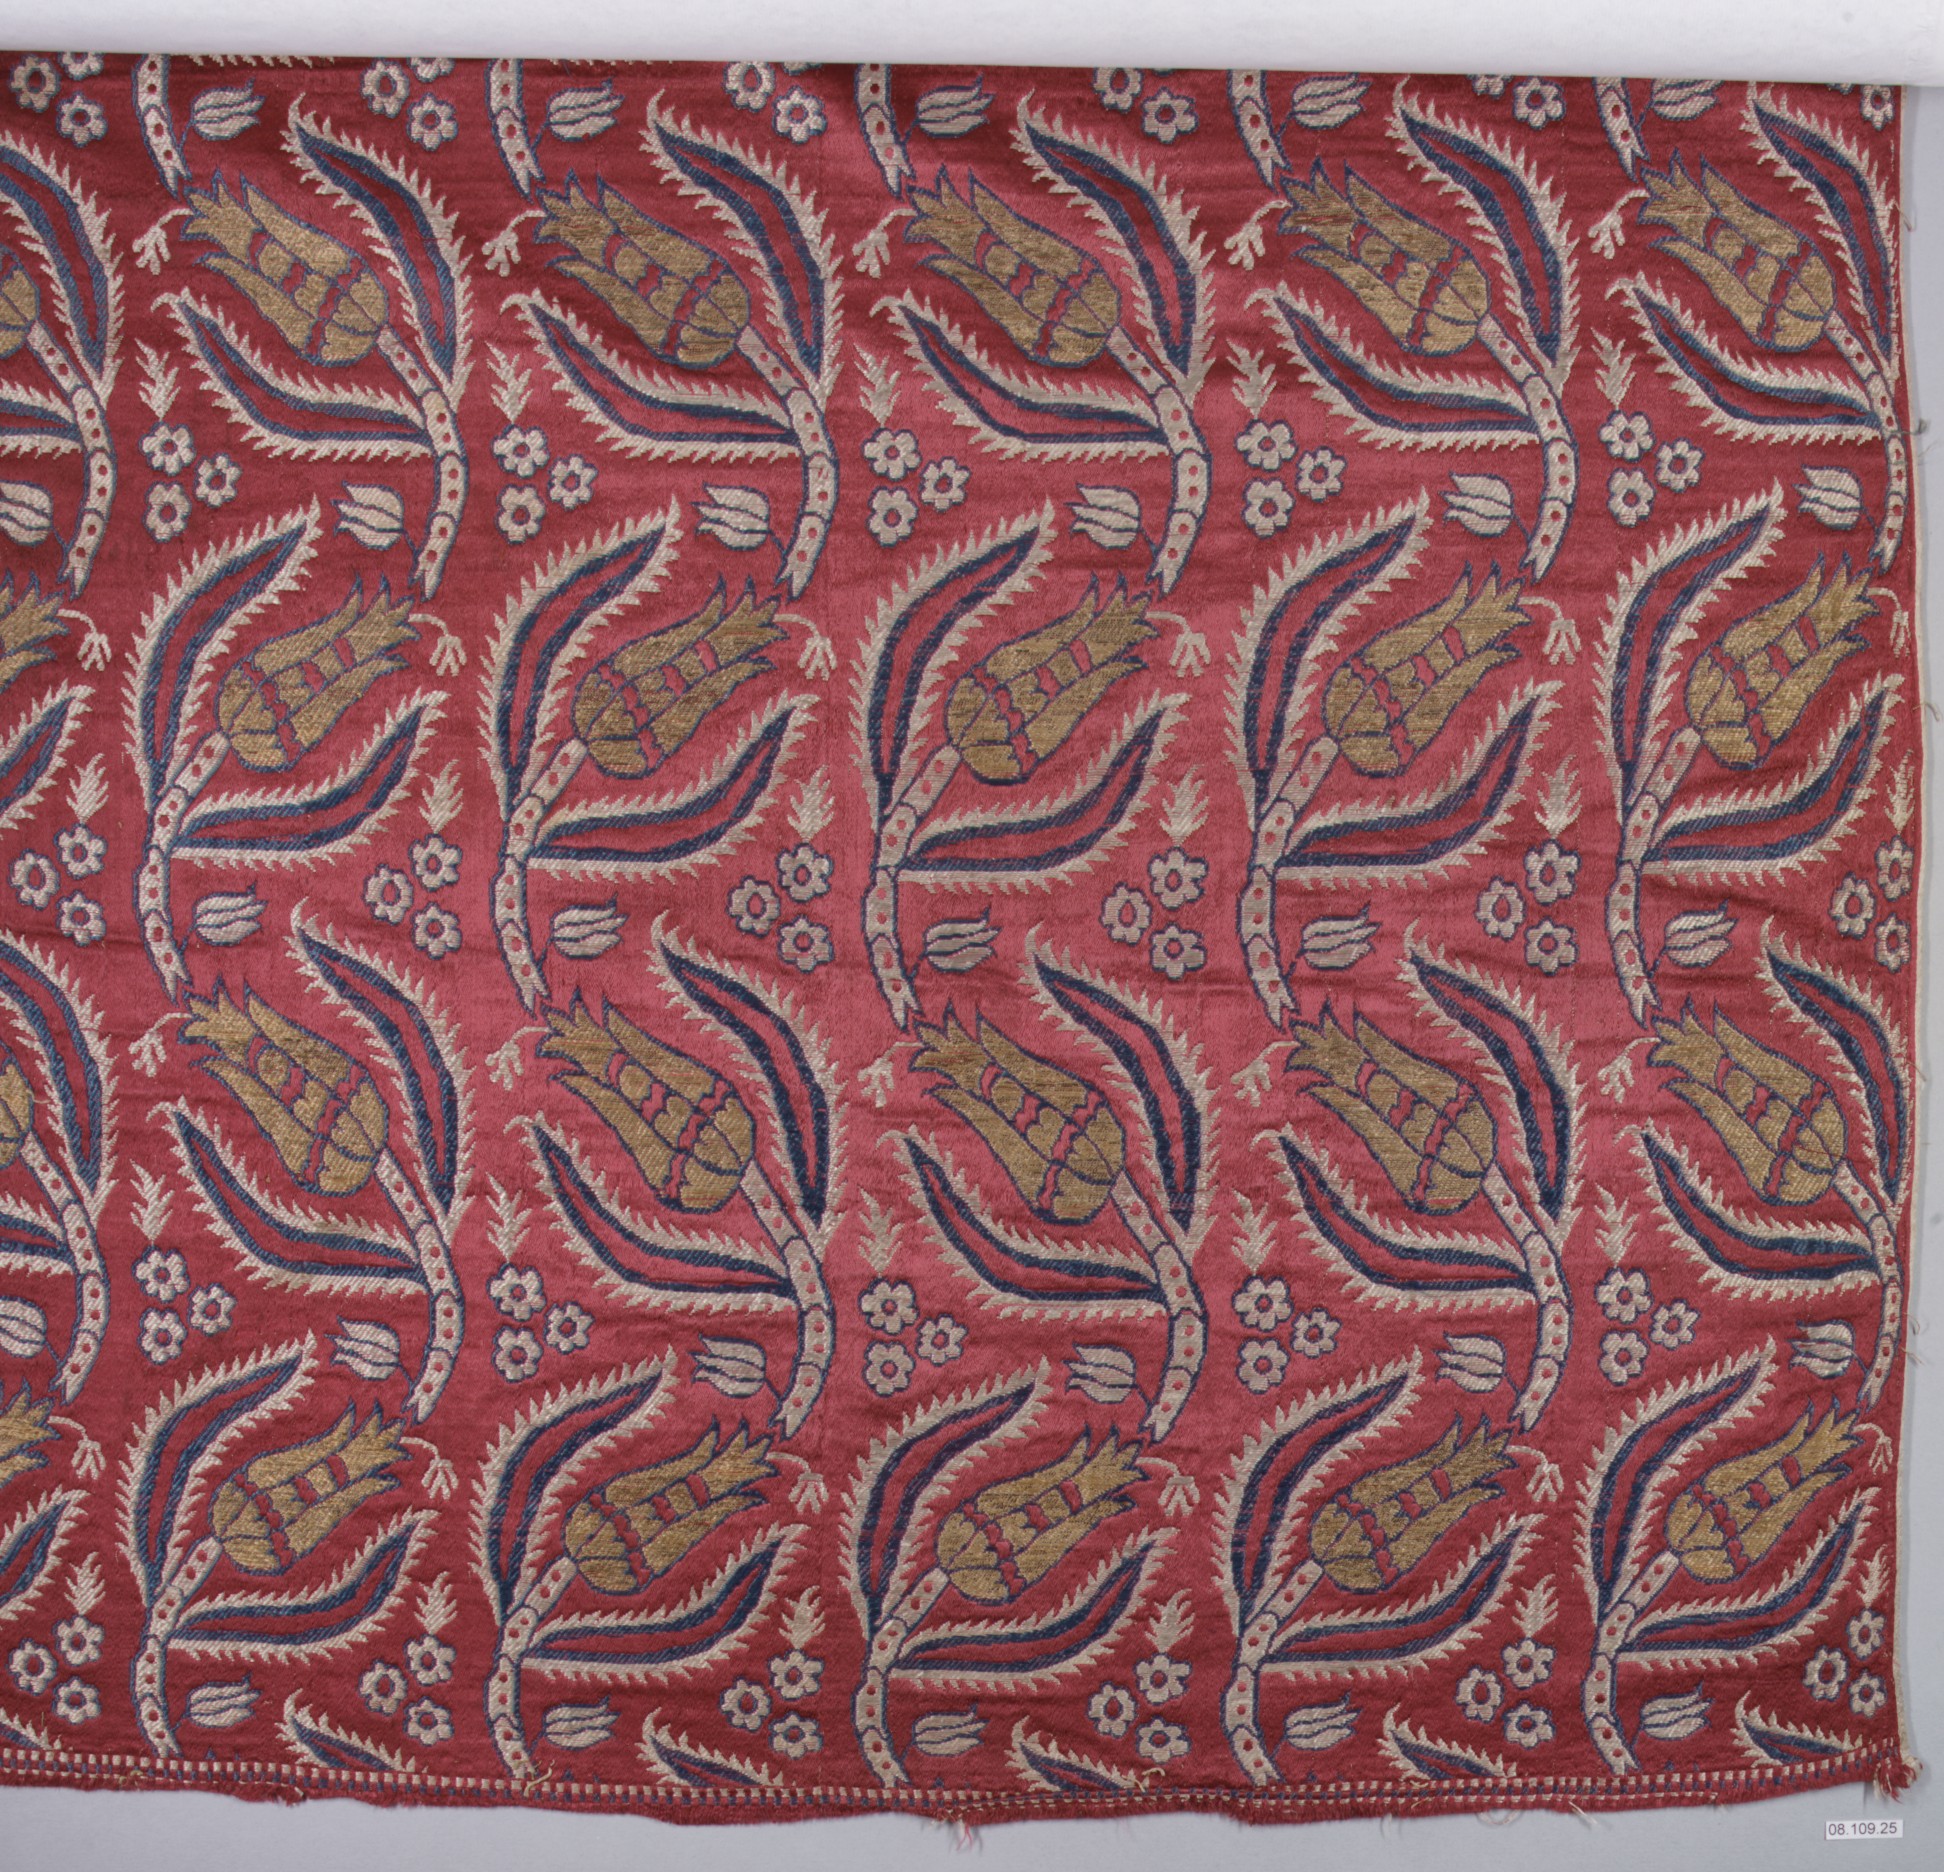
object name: brocade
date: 1501-1600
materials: metal thread, silk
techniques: brocade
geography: turkey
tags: flowers